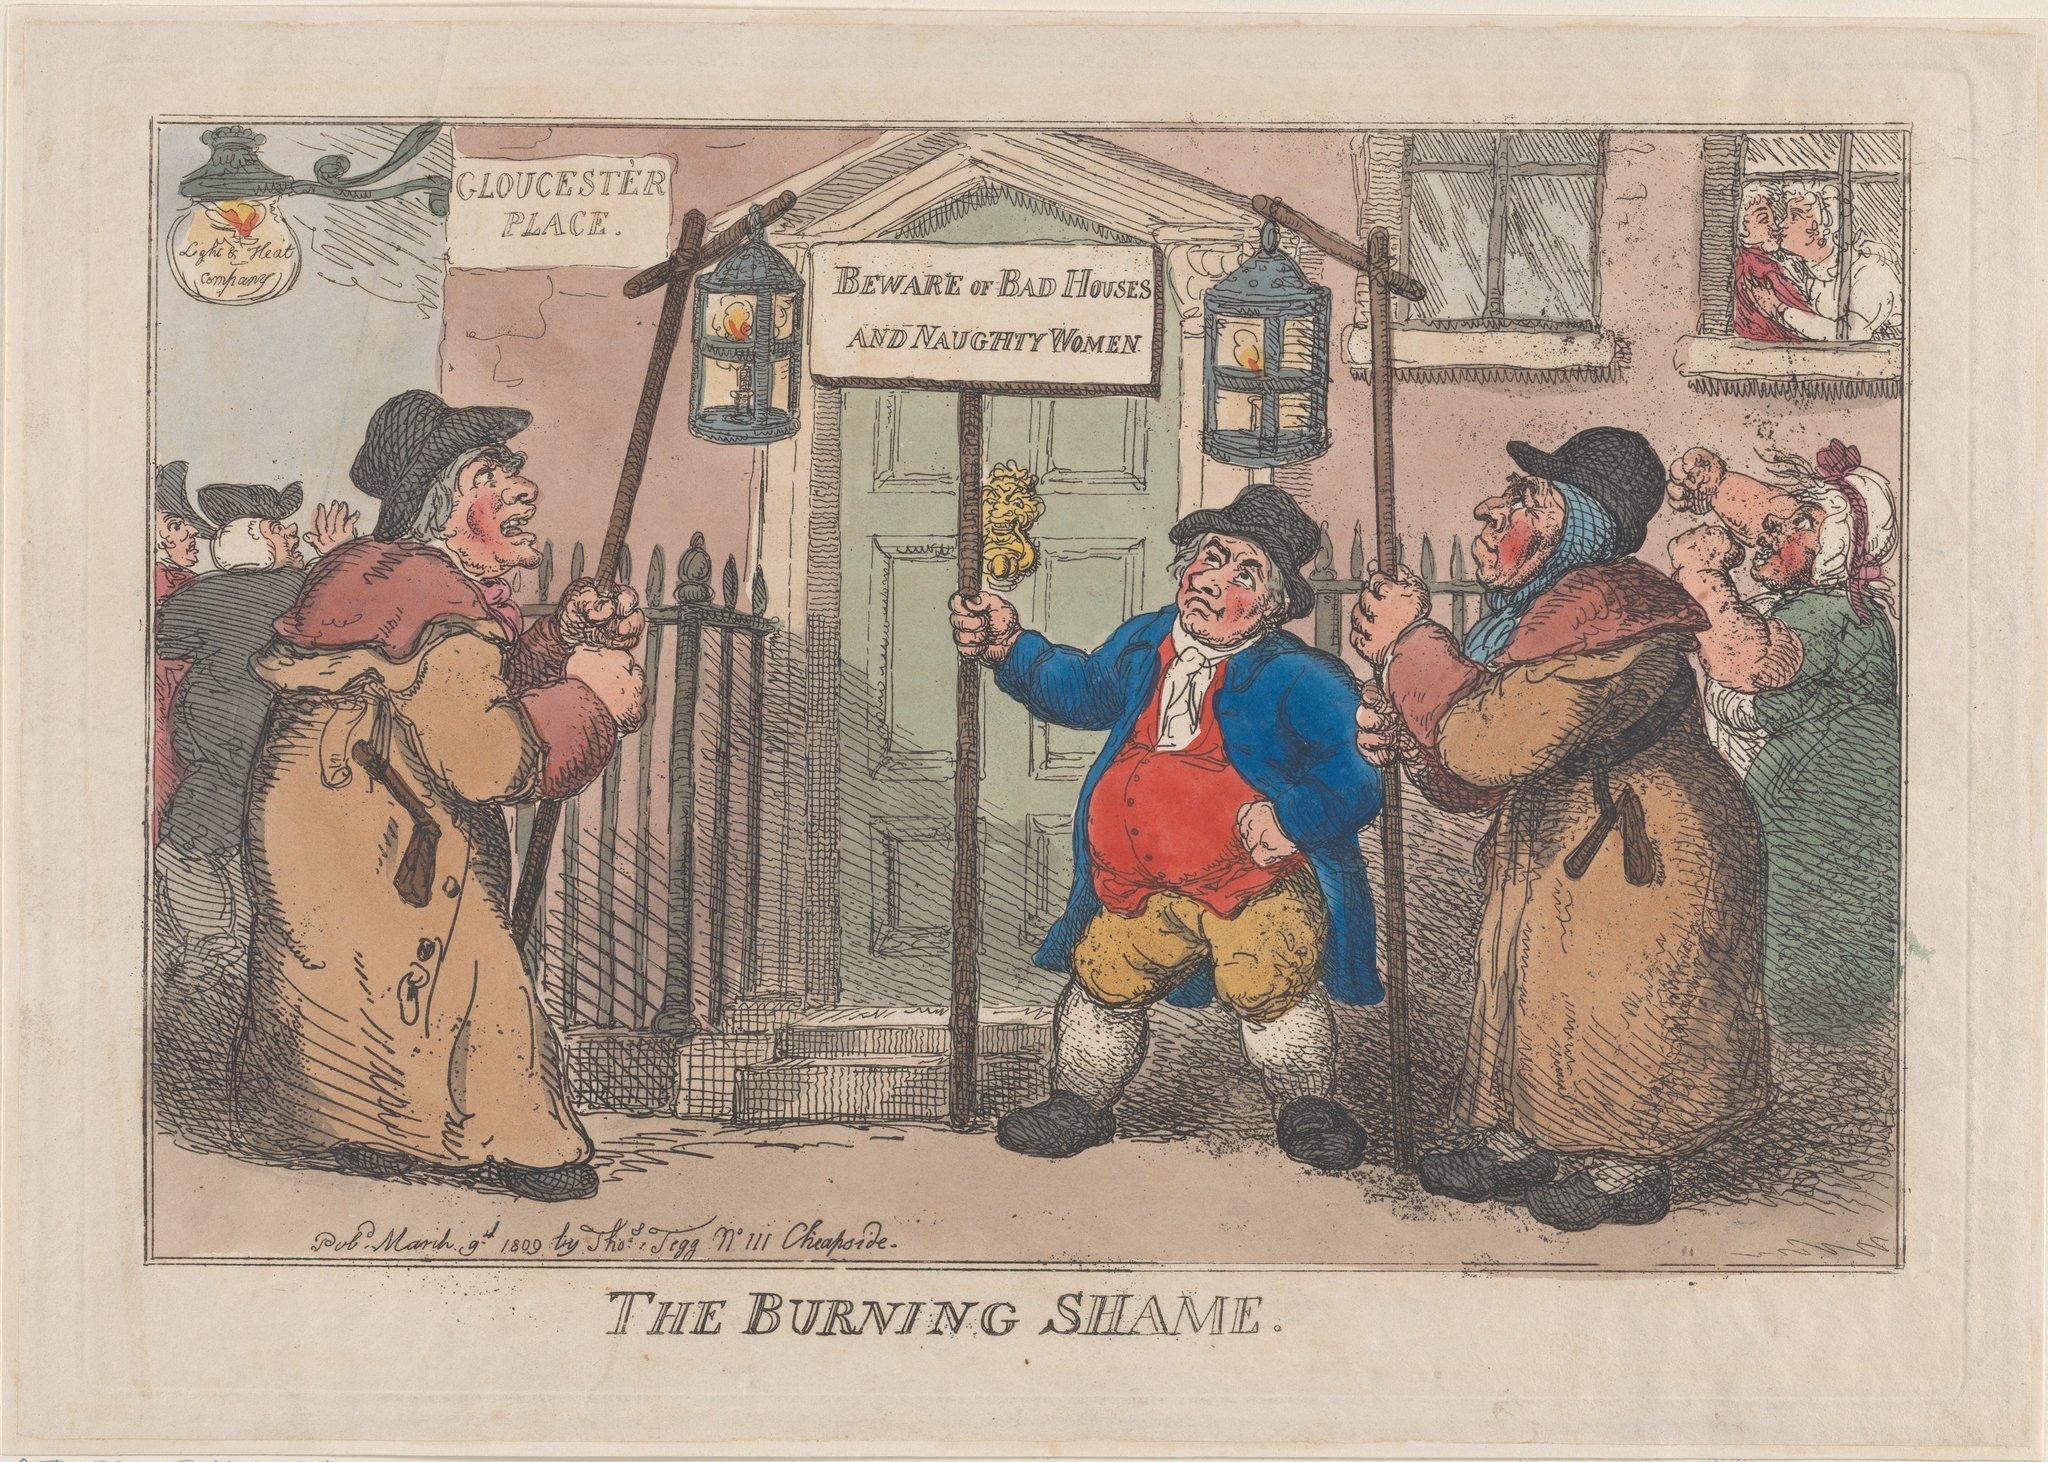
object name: print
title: The Burning Shame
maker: thomas rowlandson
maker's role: artist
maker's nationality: british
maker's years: 1757-1827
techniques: etching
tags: satire,men,politics